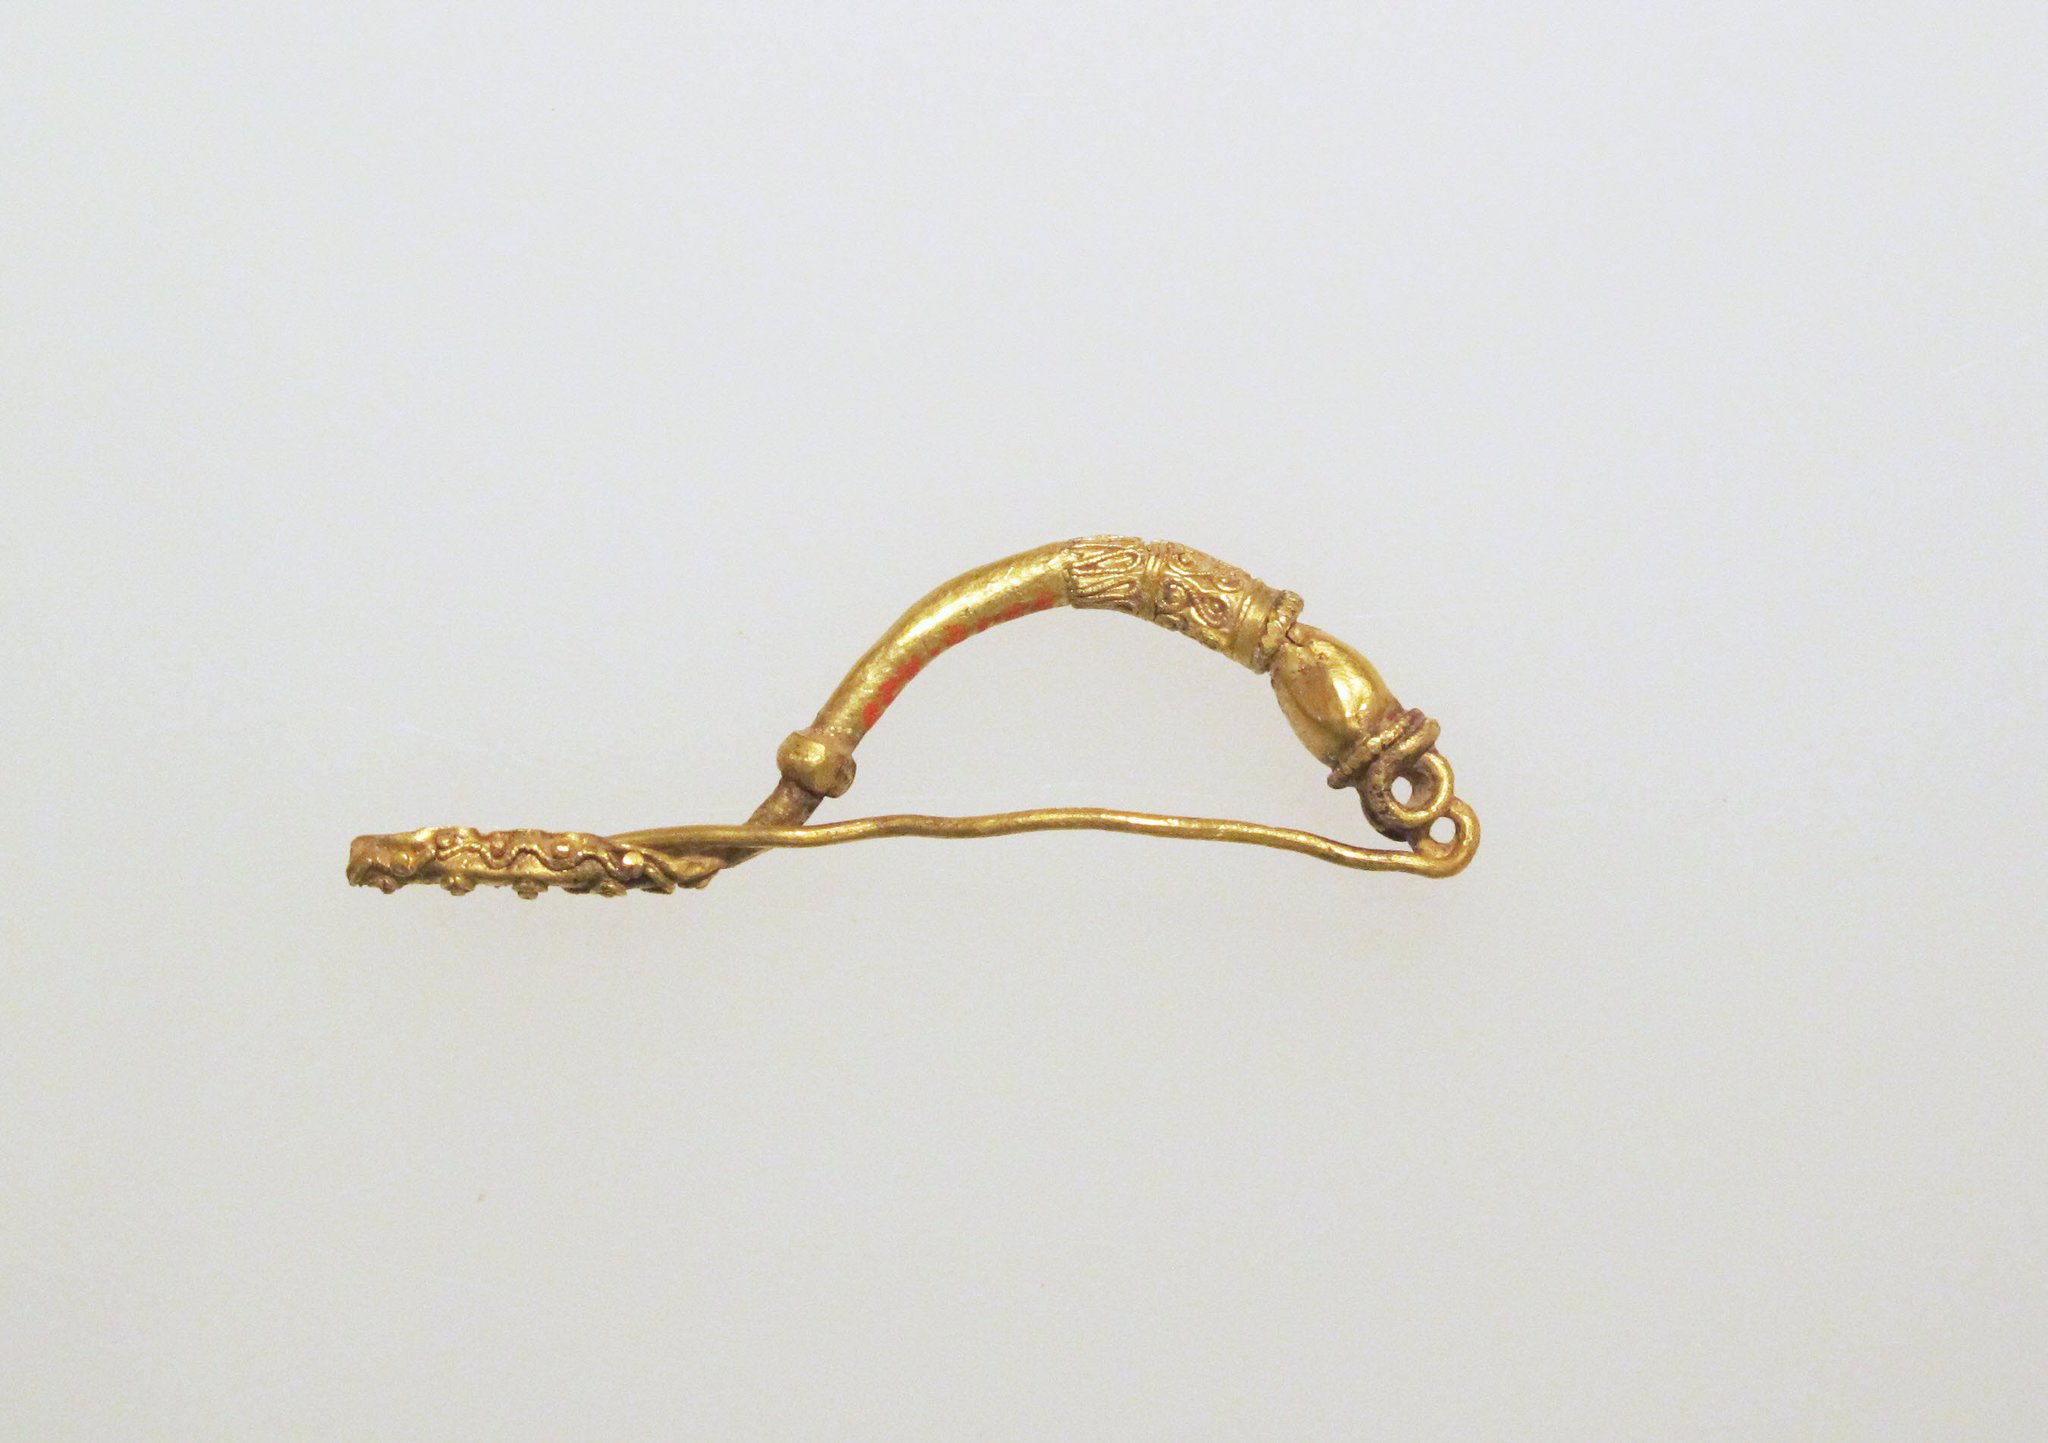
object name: fibula, bow shaped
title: Fibula, bow-shaped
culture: italic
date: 900-100 BCE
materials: gold